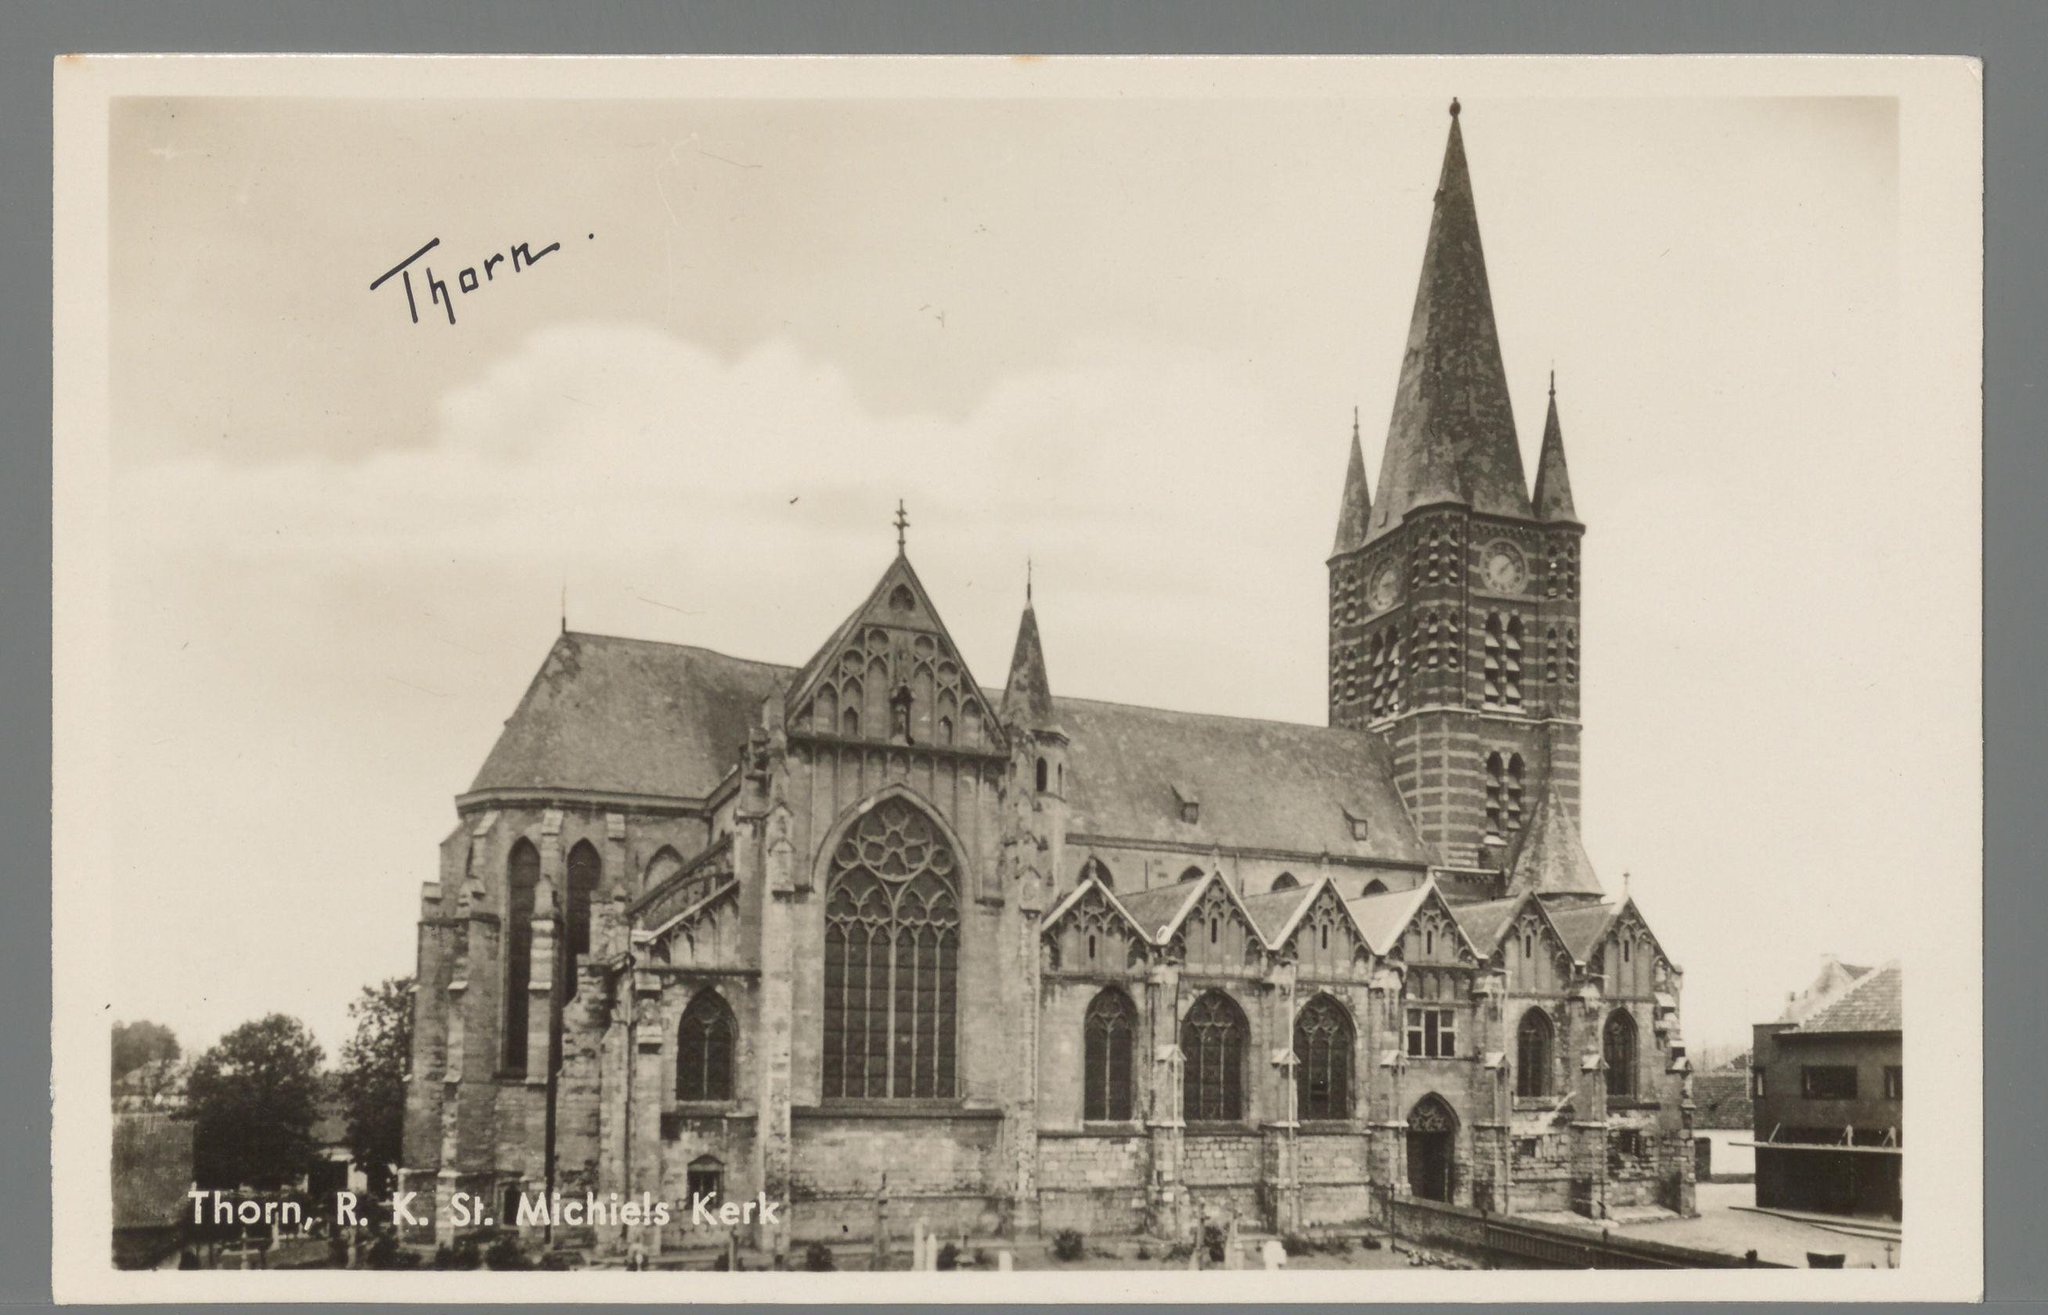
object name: photograph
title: Thorn, R. K. St. Michiels Kerk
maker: Anonymous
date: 1907-1939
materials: paper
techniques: gelatin silver print, writing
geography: thorn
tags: church (exterior)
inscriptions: date